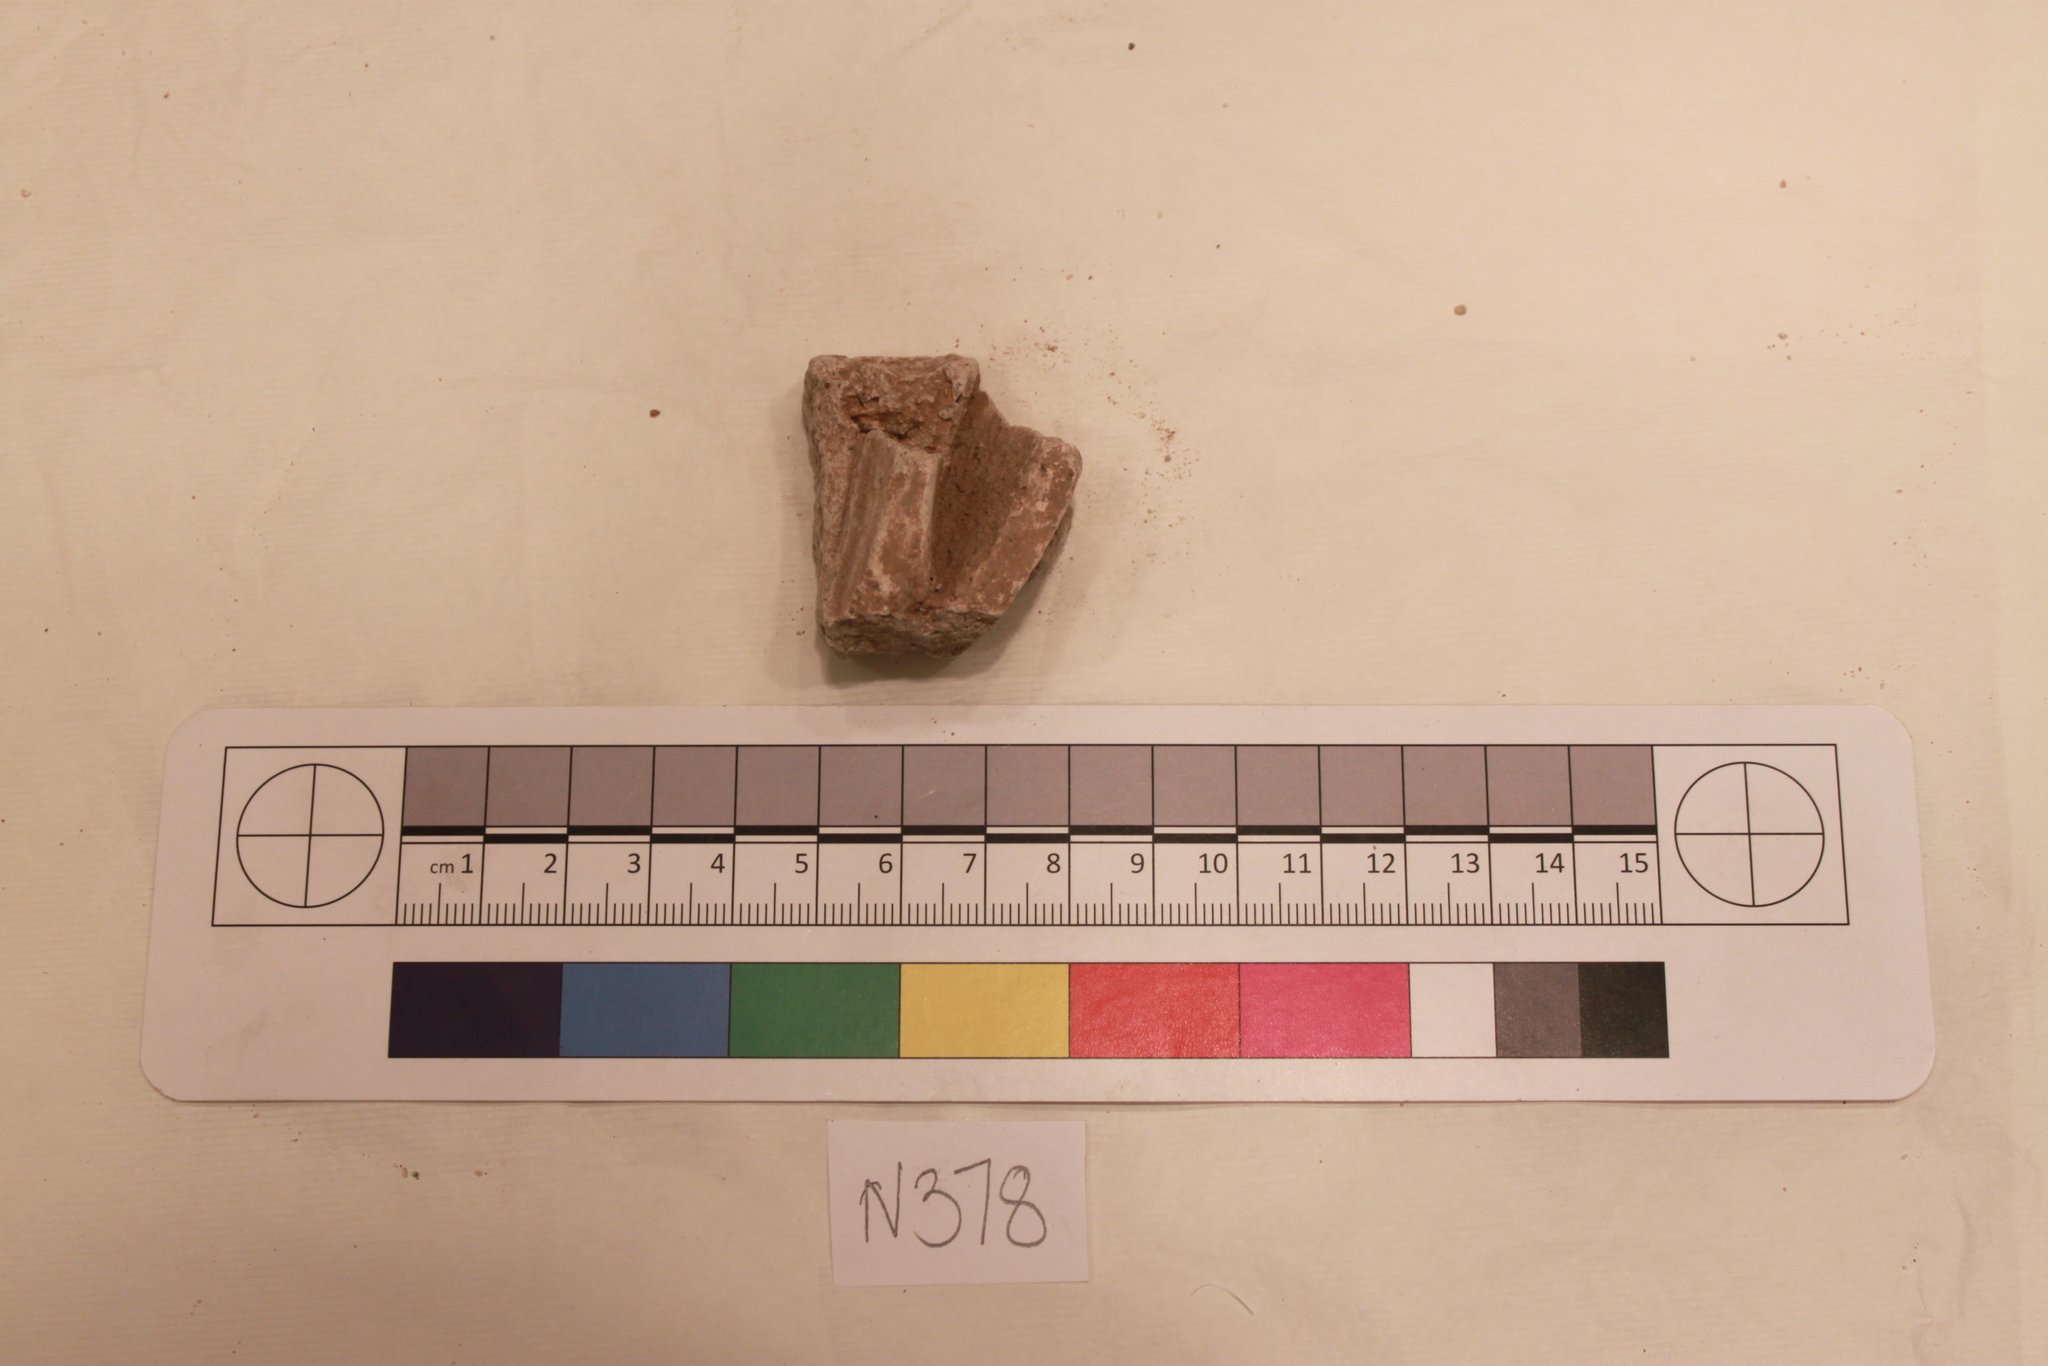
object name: fragment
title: Stucco Fragment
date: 701-1200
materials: plaster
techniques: carving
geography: iran